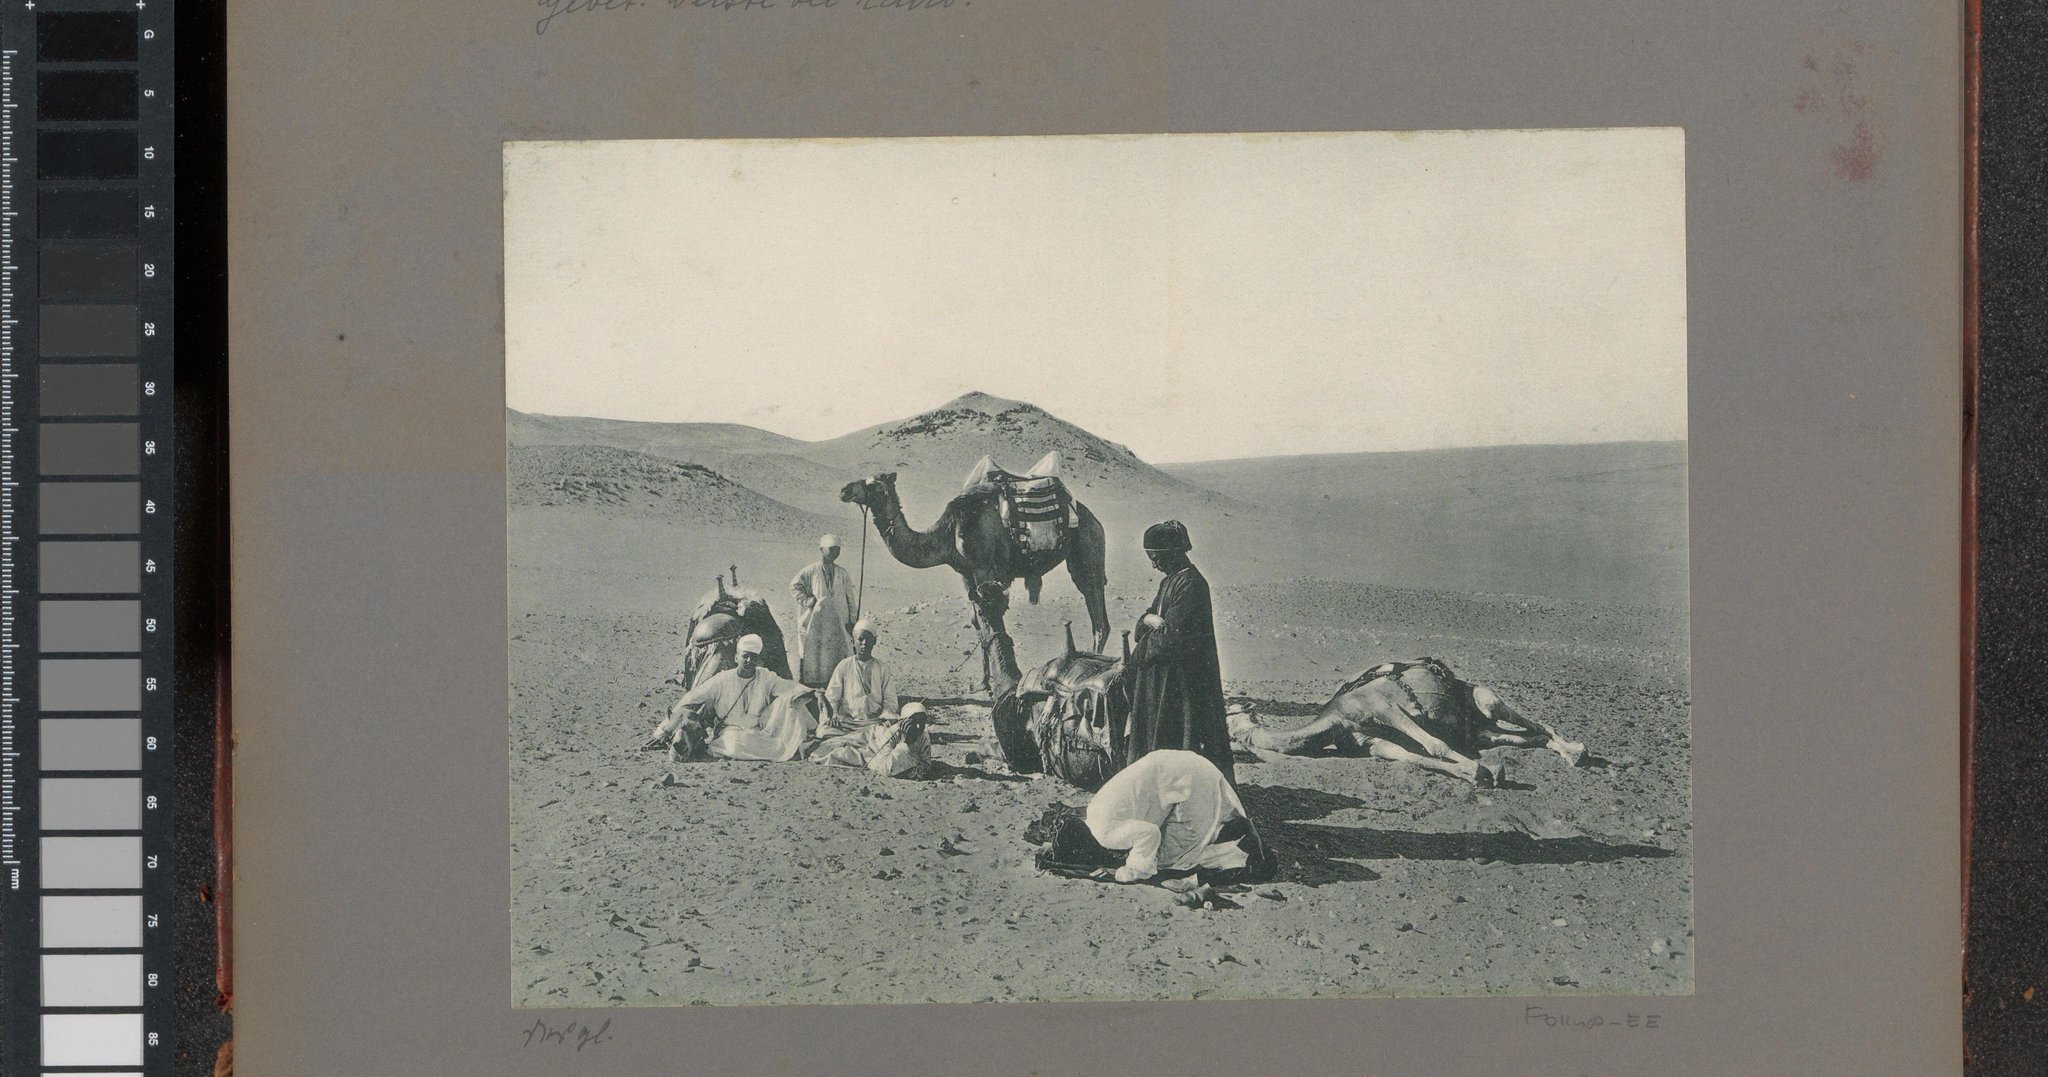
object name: album leaf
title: Kamelen en mannen in de woestijn bij Caïro, op de voorgrond een biddende man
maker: Anonymous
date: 1895-1905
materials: paper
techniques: photograph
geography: cairo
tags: hoofed animals, (private) prayer; 'oratione', 'preghiere', 'preghiere a dio' (ripa)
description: Onderdeel van Reisalbum met foto's van bezienswaardigheden in Griekenland en Egypte.